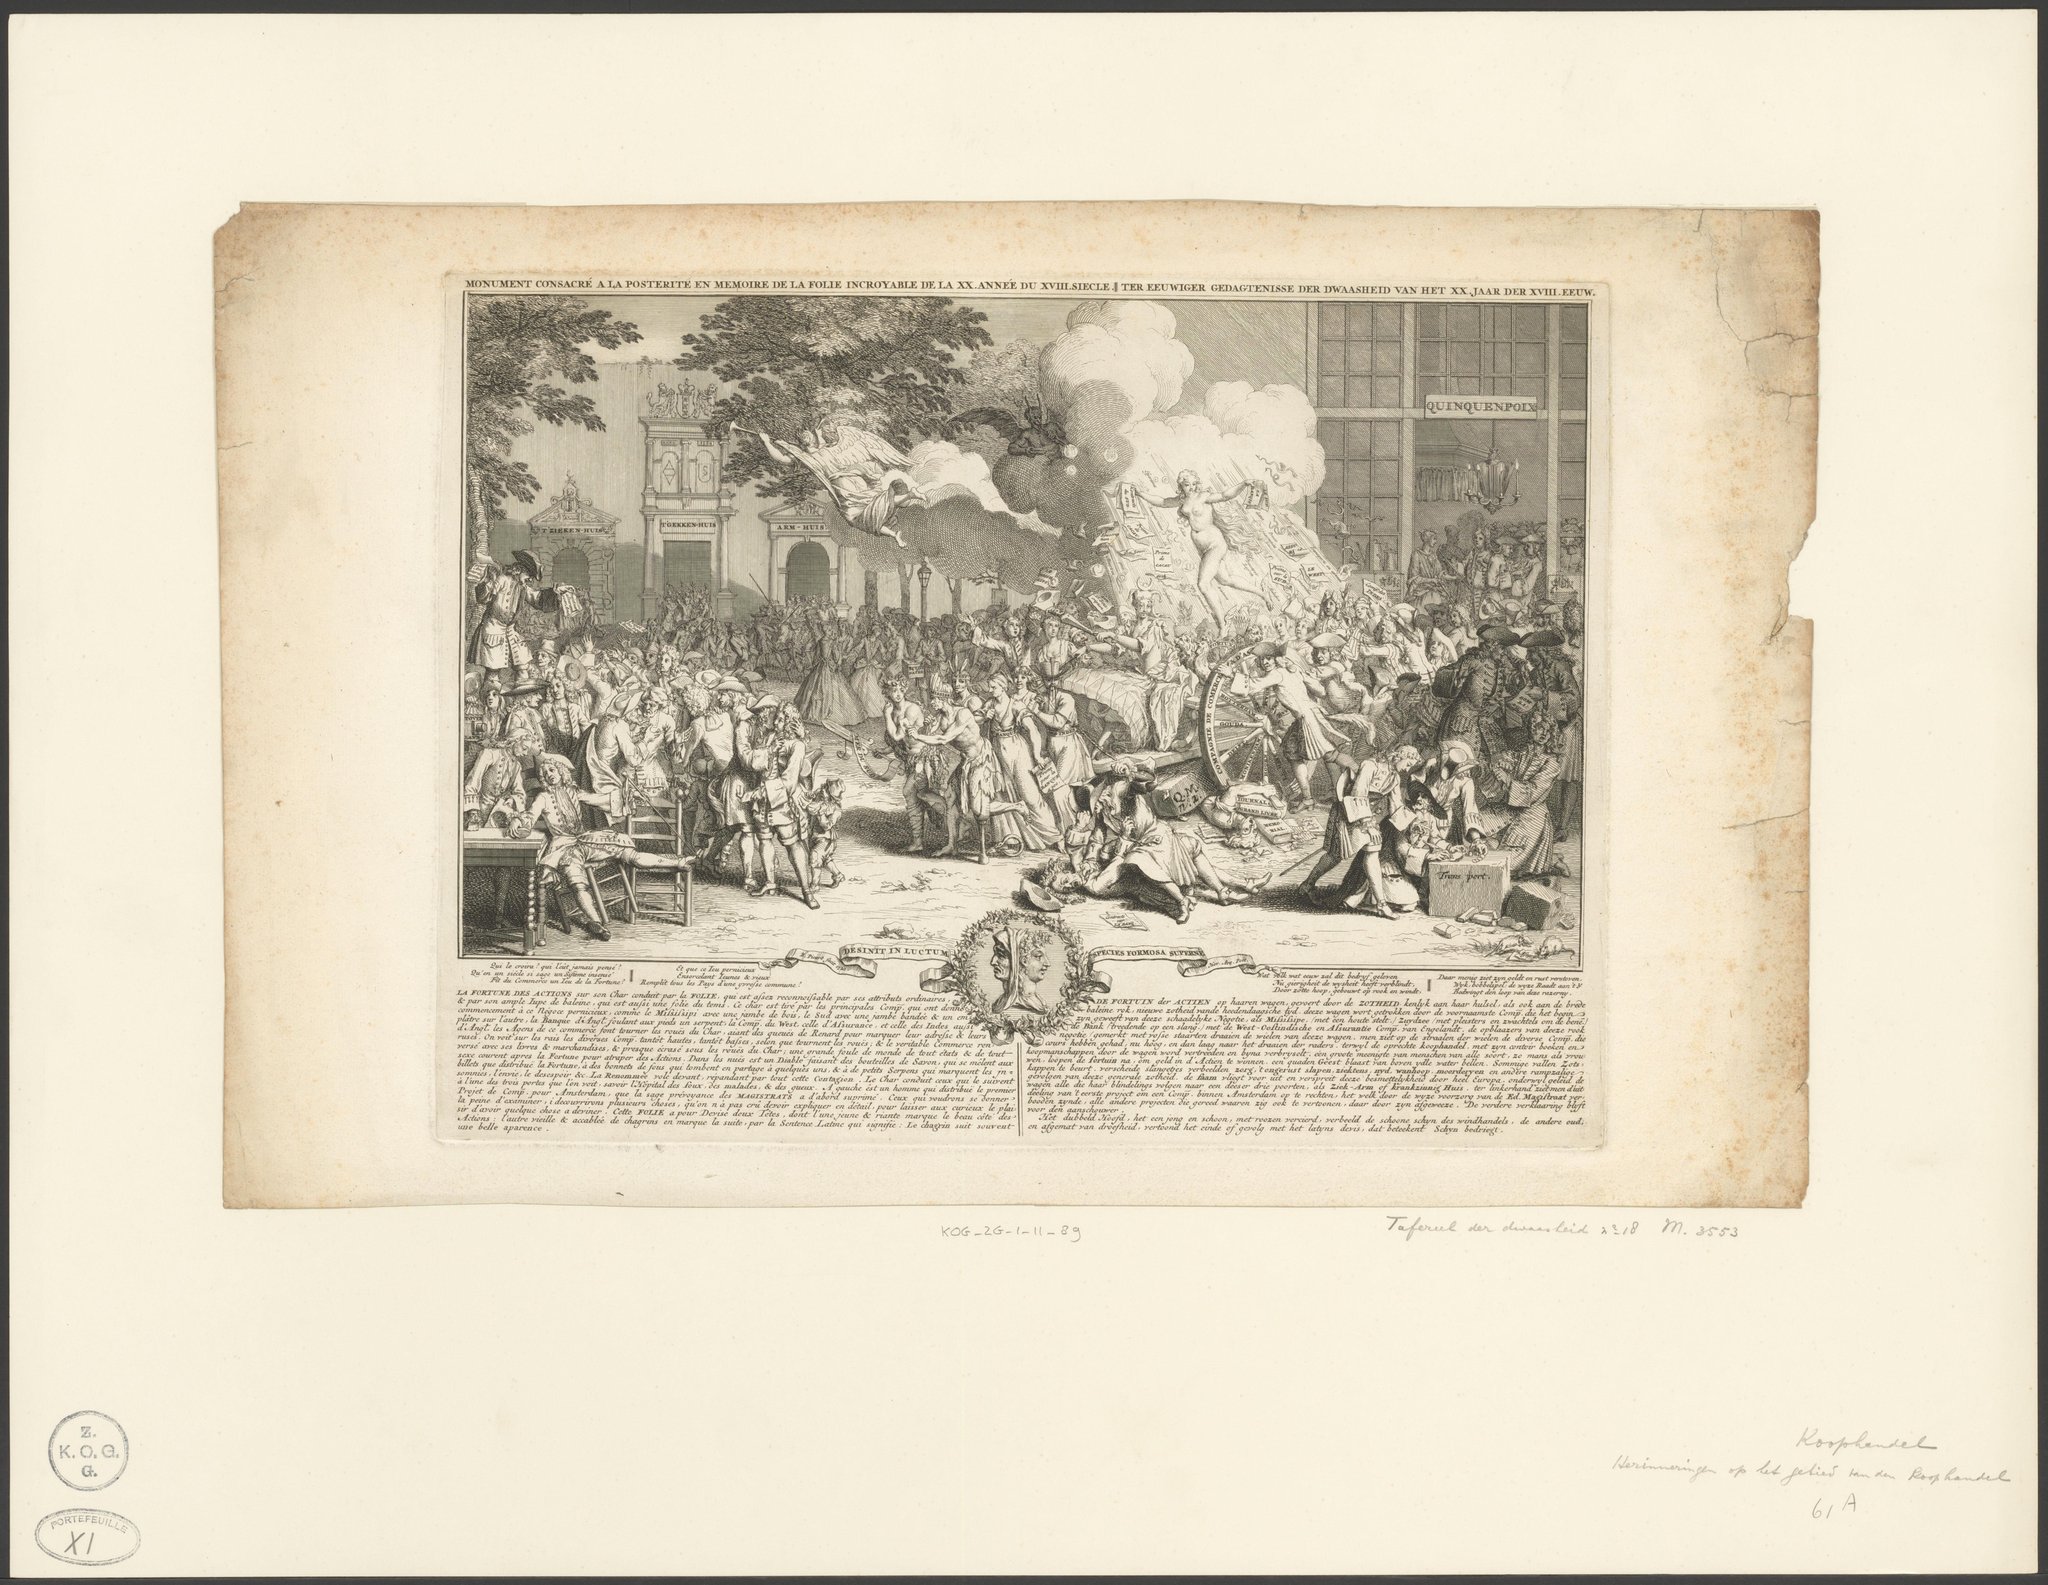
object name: print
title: Monument consacré a la posterité en memoire de la folie incroyable de la XX. année du XVIII. siecle / Ter eeuwiger gedagtenisse der dwaasheid van het XX jaar der XVIII. eeuw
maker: bernard picart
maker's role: draughtsman, print maker, publisher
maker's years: 1673-1733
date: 1720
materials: paper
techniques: engraving, etching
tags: financial panic, indigenous peoples of north america, indigenous peoples of south america, luck, fortune, lot; 'fato', 'fortuna', 'fortuna aurea', 'fortuna buona', 'fortuna pacifica overo clemente', 'sorte' (ripa), lunatic asylum, mental home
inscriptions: stamp, collector's mark: Lugt 1641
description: Monument ter herinnering aan de dwaasheid van het jaar 1720. Op een grote wagen gemend door een nar strooit de Fortuin van de Actiën aandelen in het rond. De kar wordt getrokken door onder anderen personificaties van de compagnieën van de Zuidzee en Mississippi. De wagen wordt door de Faam geleid in de richting van het armenhuis en gekkenhuis. Om de kar heen handelaren en gedupeerden. Rechts op de achtergrond het koffiehuis Quincampoix. Onderaan het embleem met de motto Schijn Bedriegt in het Latijn. In het onderschrift de verklaring van de voorstelling in het Frans en Nederlands. Prent 18 in de serie Het Groote Tafereel der Dwaasheid met spotprenten op de Windhandel of Actiehandel van 1720. Onderwerpsrubrieken binnen de Atlas Zeden en Gewoonten: Handel, nijverheid en verkeer, Koophandel, Veilingen, Makelaardij en Verzekeringswezen, Herinneringen op het gebied van den Koophandel.